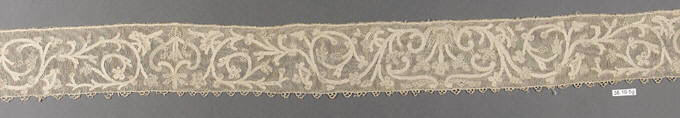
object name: hebrew ritual lace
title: Hebrew ritual lace (one of four)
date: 1701-1733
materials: silk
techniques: lace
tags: ritual objects